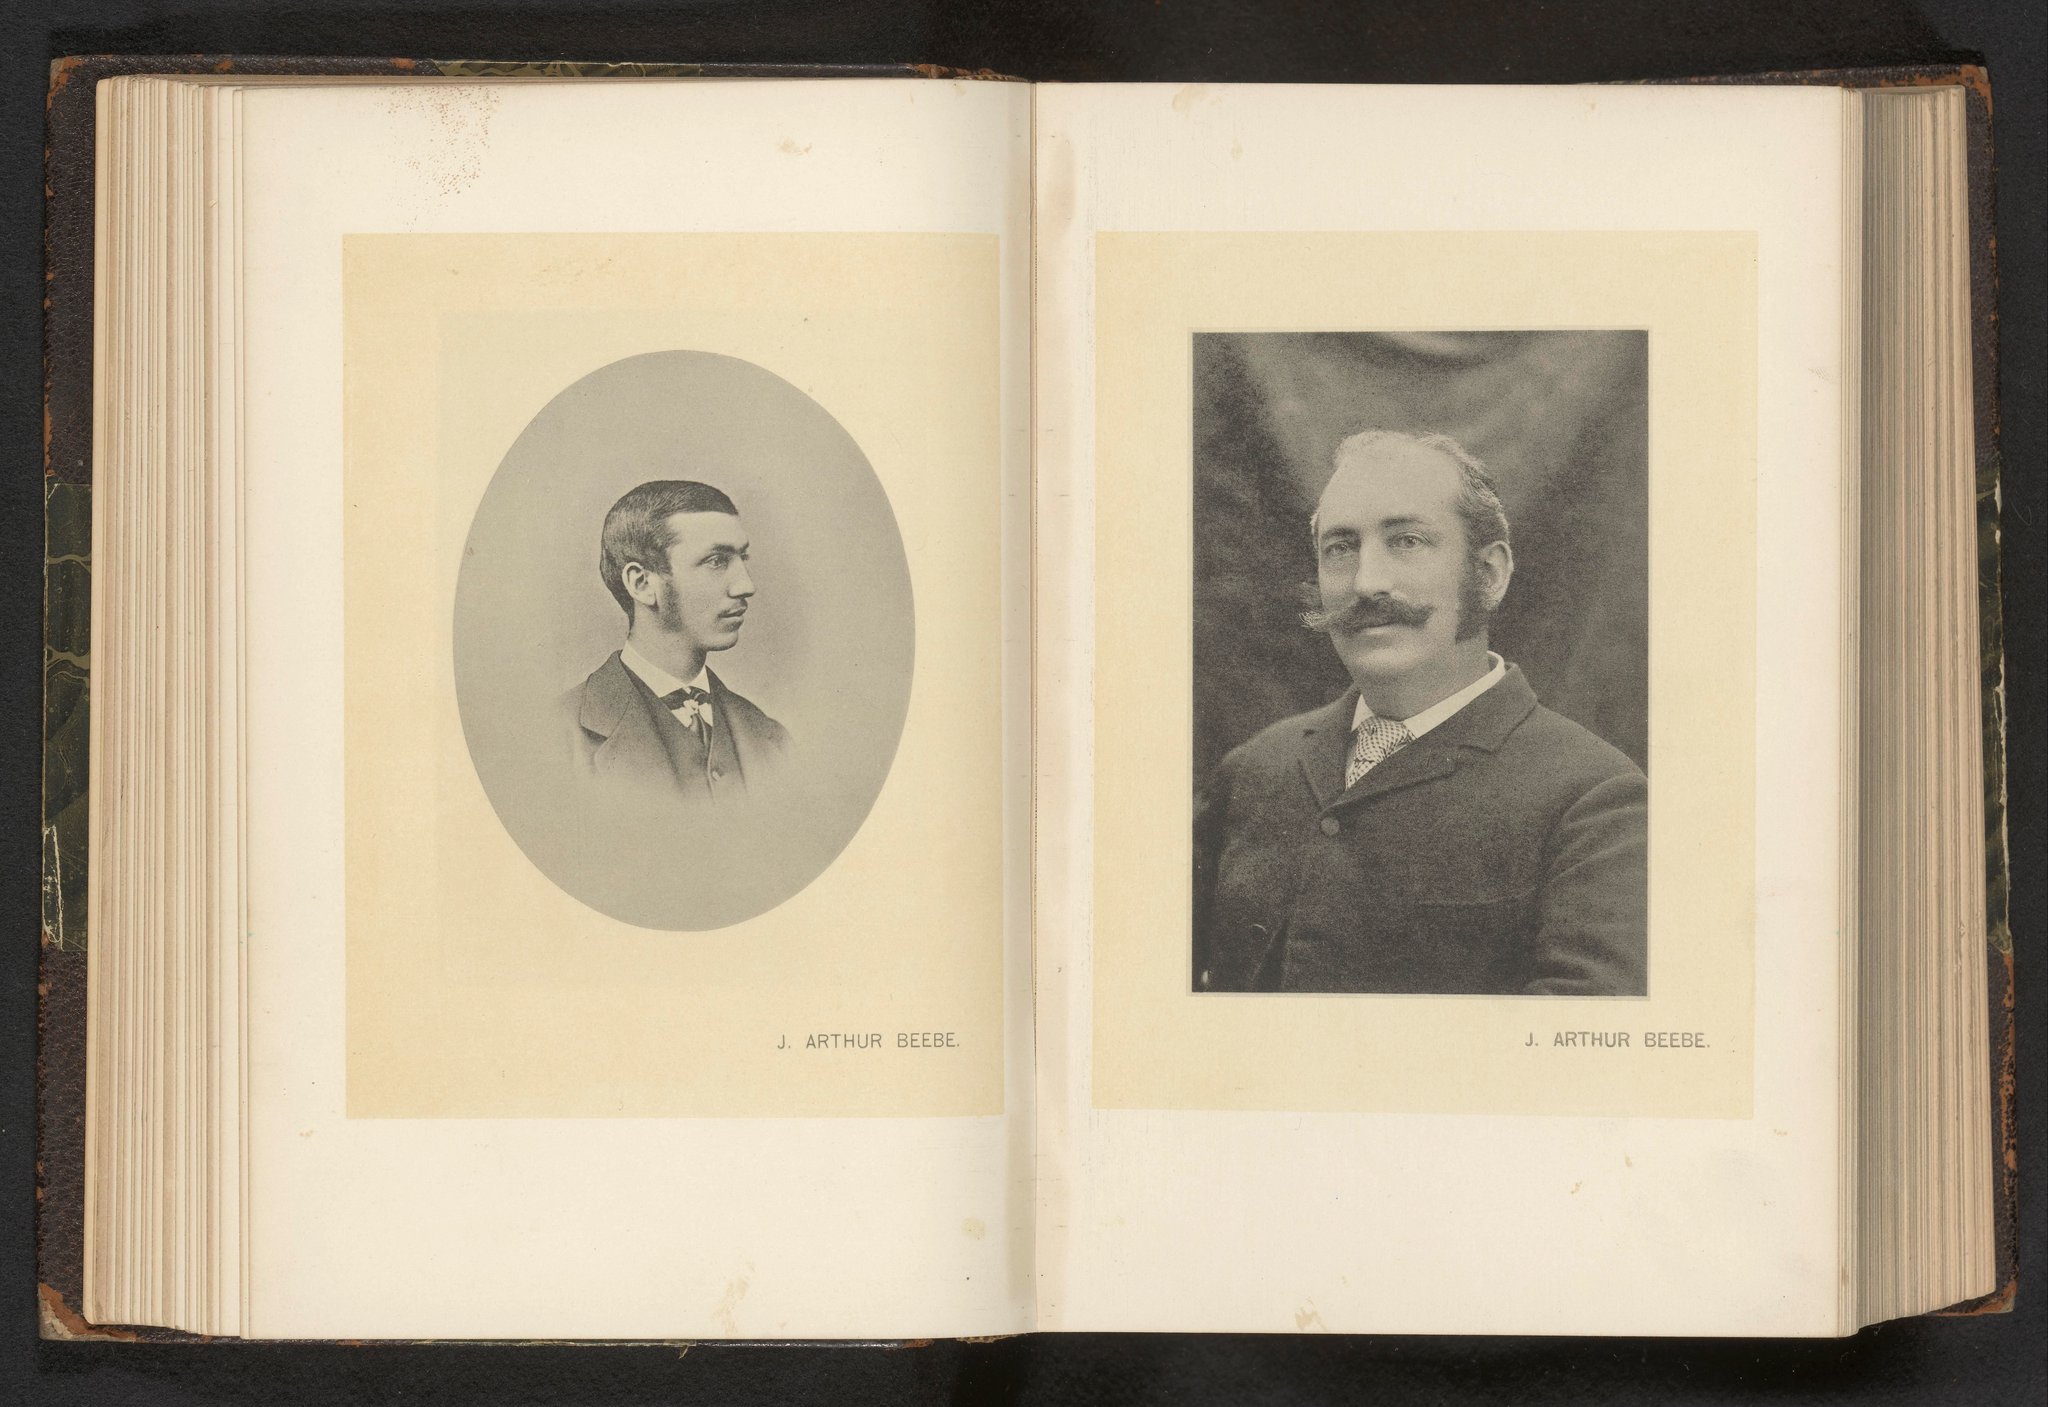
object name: photomechanical print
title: J. Arthur Beebe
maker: Anonymous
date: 1869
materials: paper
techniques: photoaquatint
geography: boston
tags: adult man